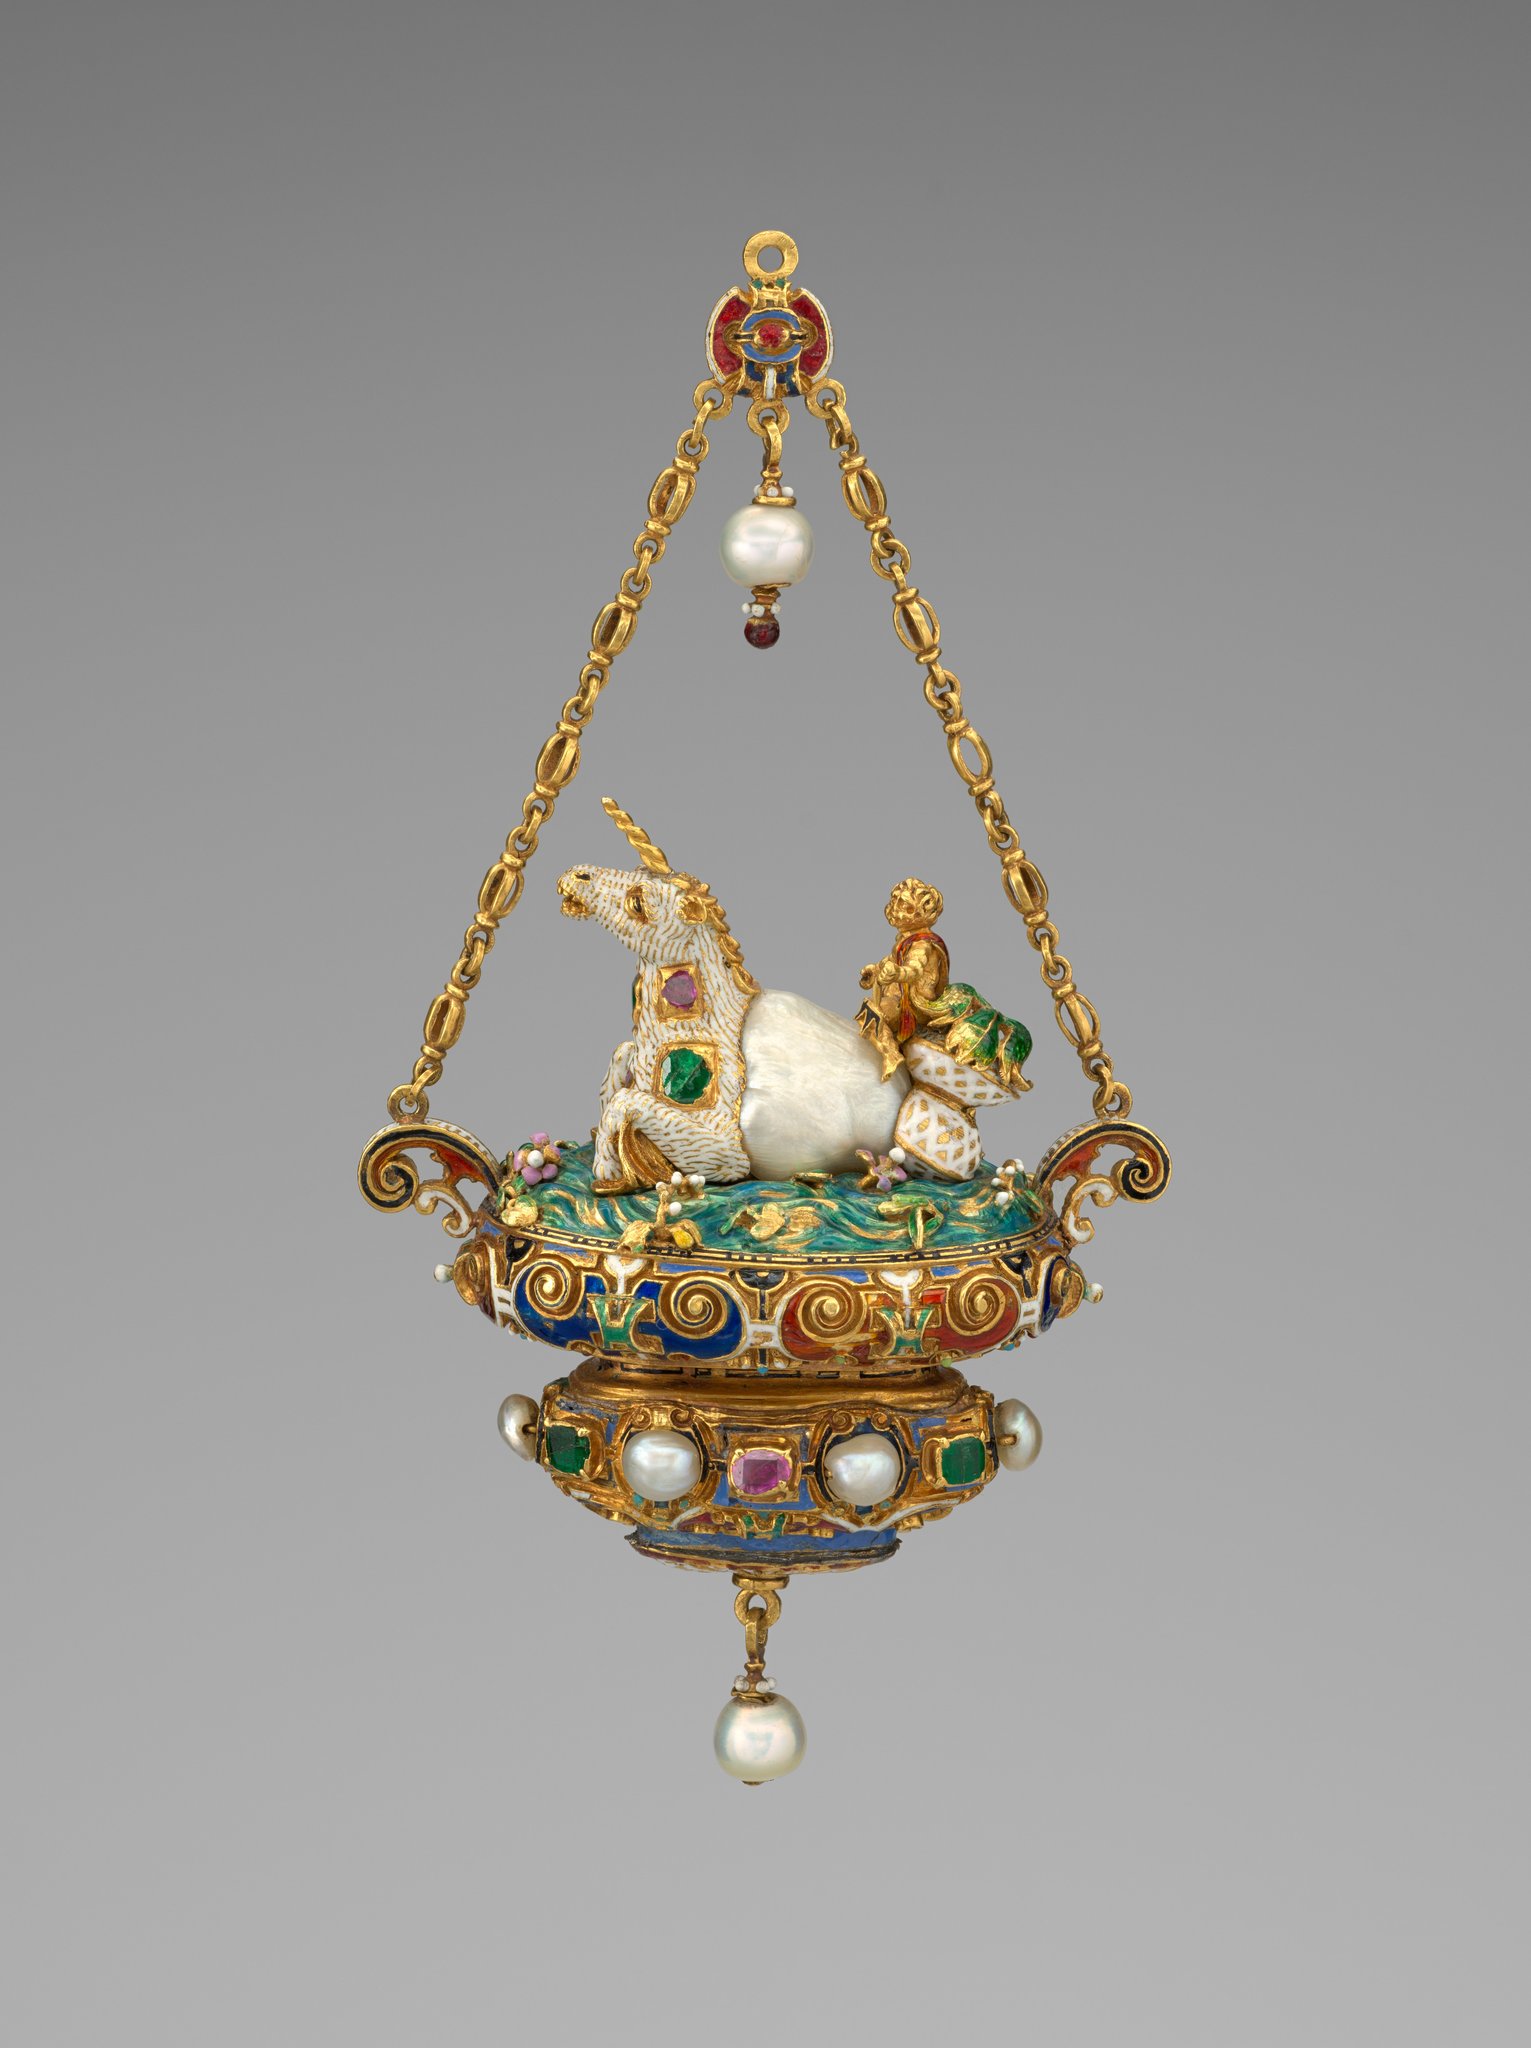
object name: pendant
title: Pendant with a Triton Riding a Unicorn-like Sea Creature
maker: reinhold vasters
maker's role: designer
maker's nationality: german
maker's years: 1827-1909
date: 1870-1895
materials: gemstone, gold, pearl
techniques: enamel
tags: triton,unicorns